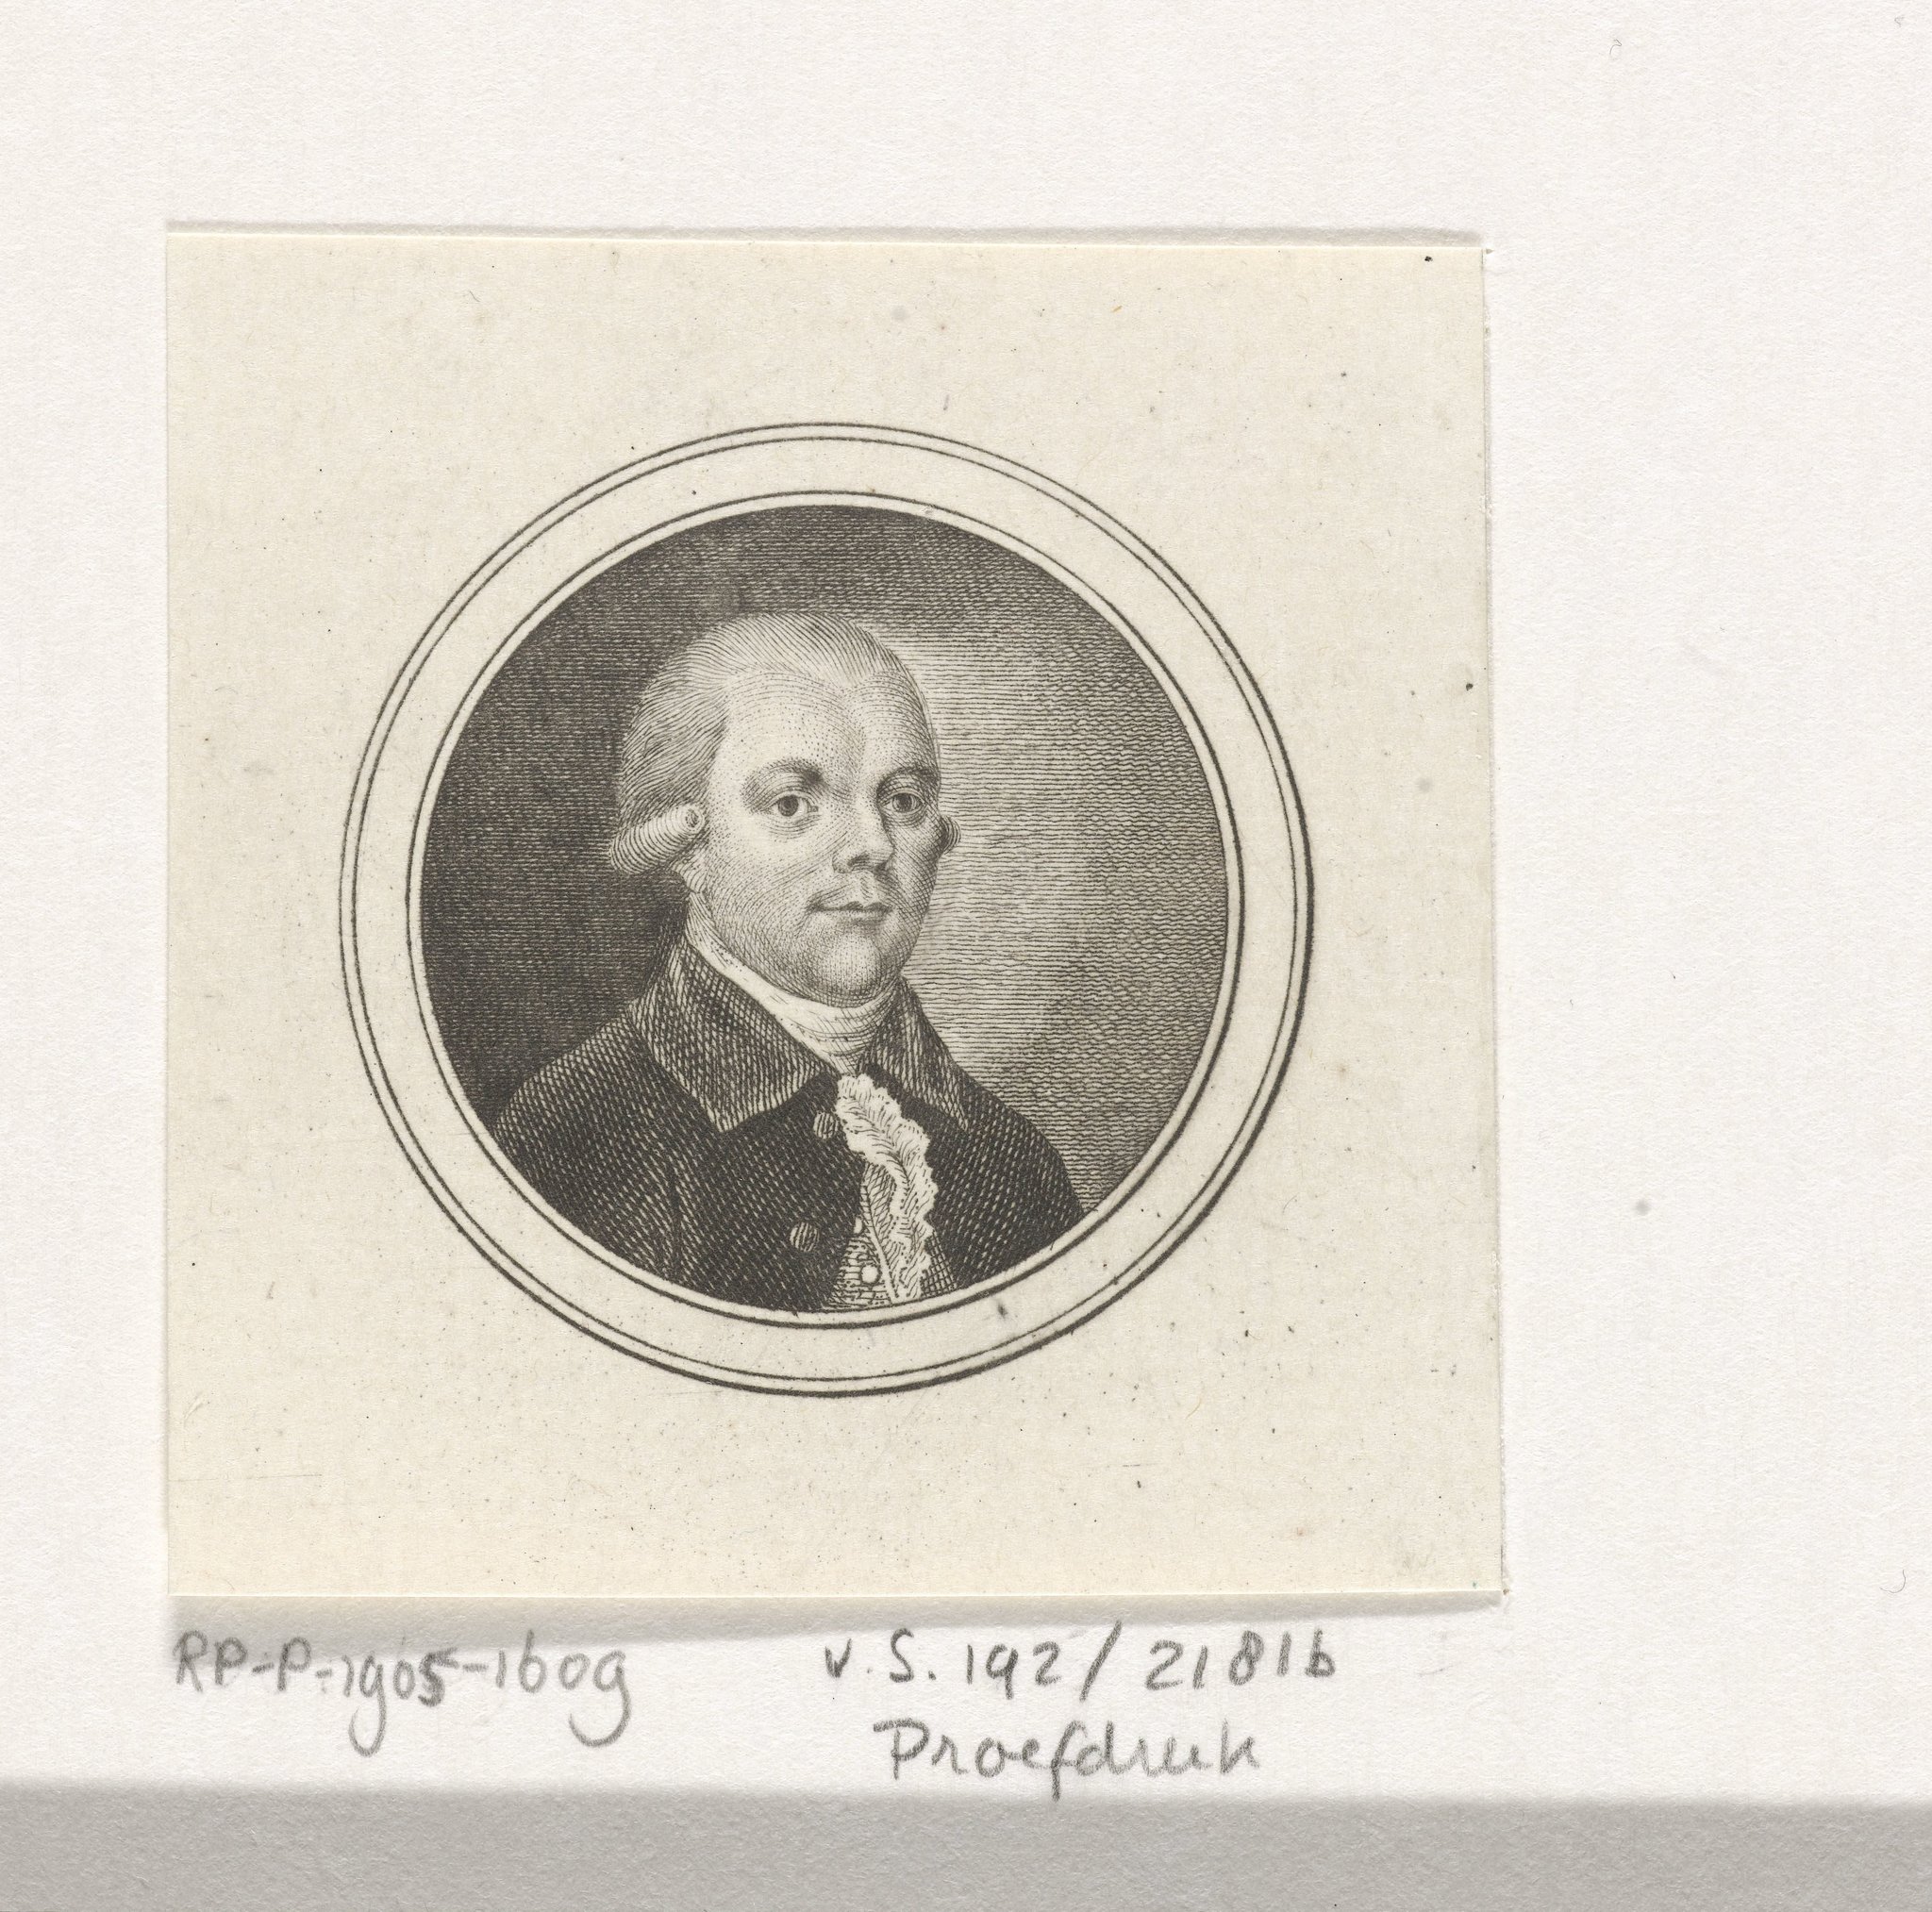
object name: print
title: Portret van Cornelis de Gijselaar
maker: abraham jacobsz. hulk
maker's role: print maker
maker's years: 1751-1817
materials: paper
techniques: engraving, etching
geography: paris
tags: gorinchem, pensionaris, cornelis de gijselaar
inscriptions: collector's mark: Lugt 2228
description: De plaat van deze prent werd door Jacobus Wijsman aangepast en hergebruikt in zijn eigen serie patriottenportretten.